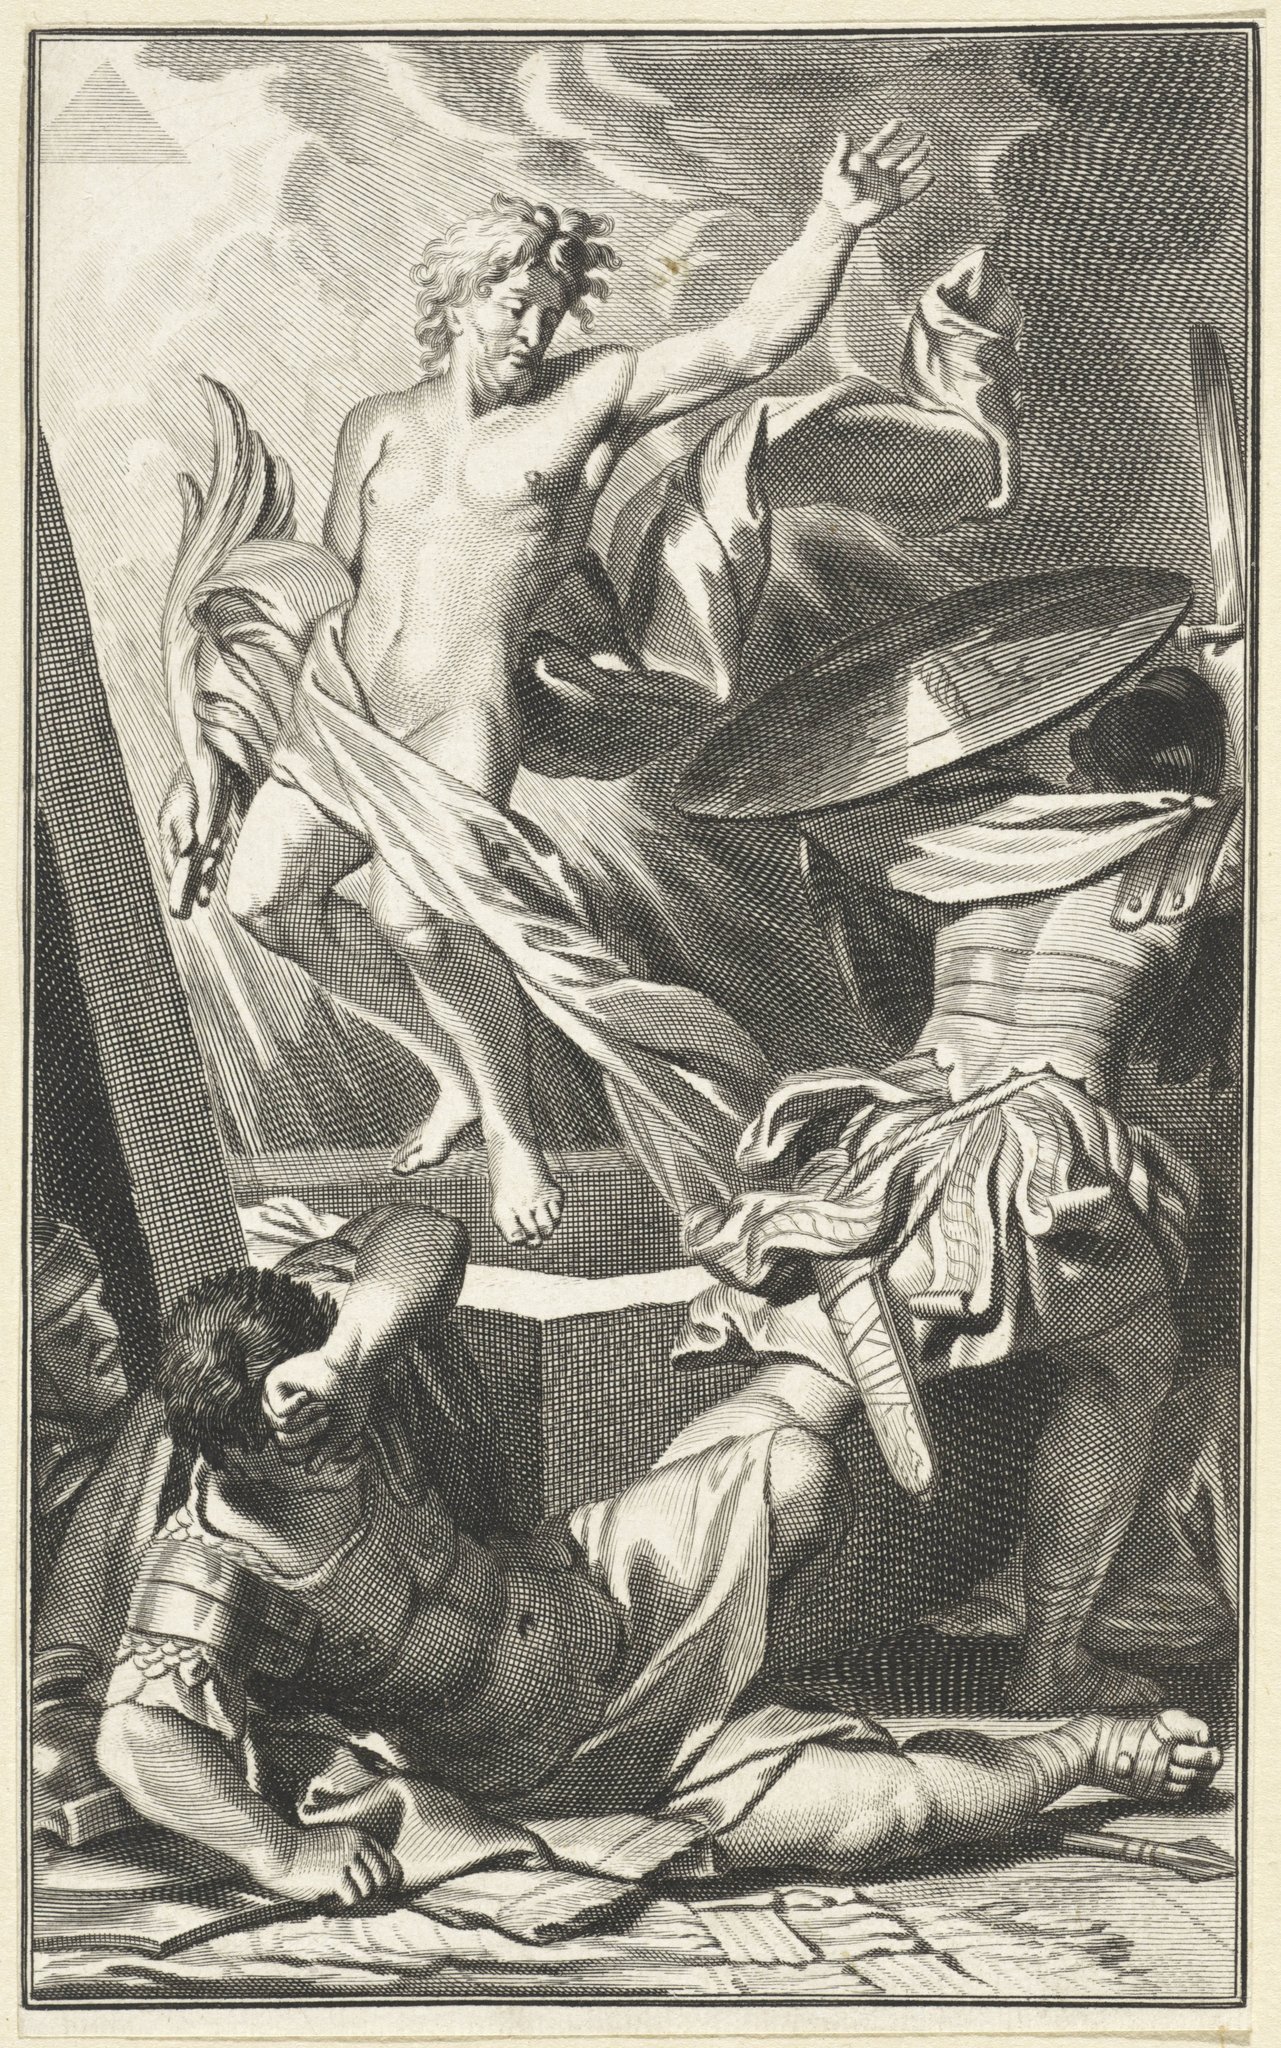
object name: print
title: Opstanding van Christus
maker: Anonymous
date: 1655-1731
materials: paper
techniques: engraving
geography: northern netherlands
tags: christ, usually holding a banner, arises from the grave; often combined with sleeping and/or frightened soldiers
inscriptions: collector's mark: Lugt 240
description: Christus zweeft met een palmtak in zijn hand uit de tombe. Vooraan liggen twee soldaten op de grond. Rechts heft een soldaat zijn zwaard en schild.